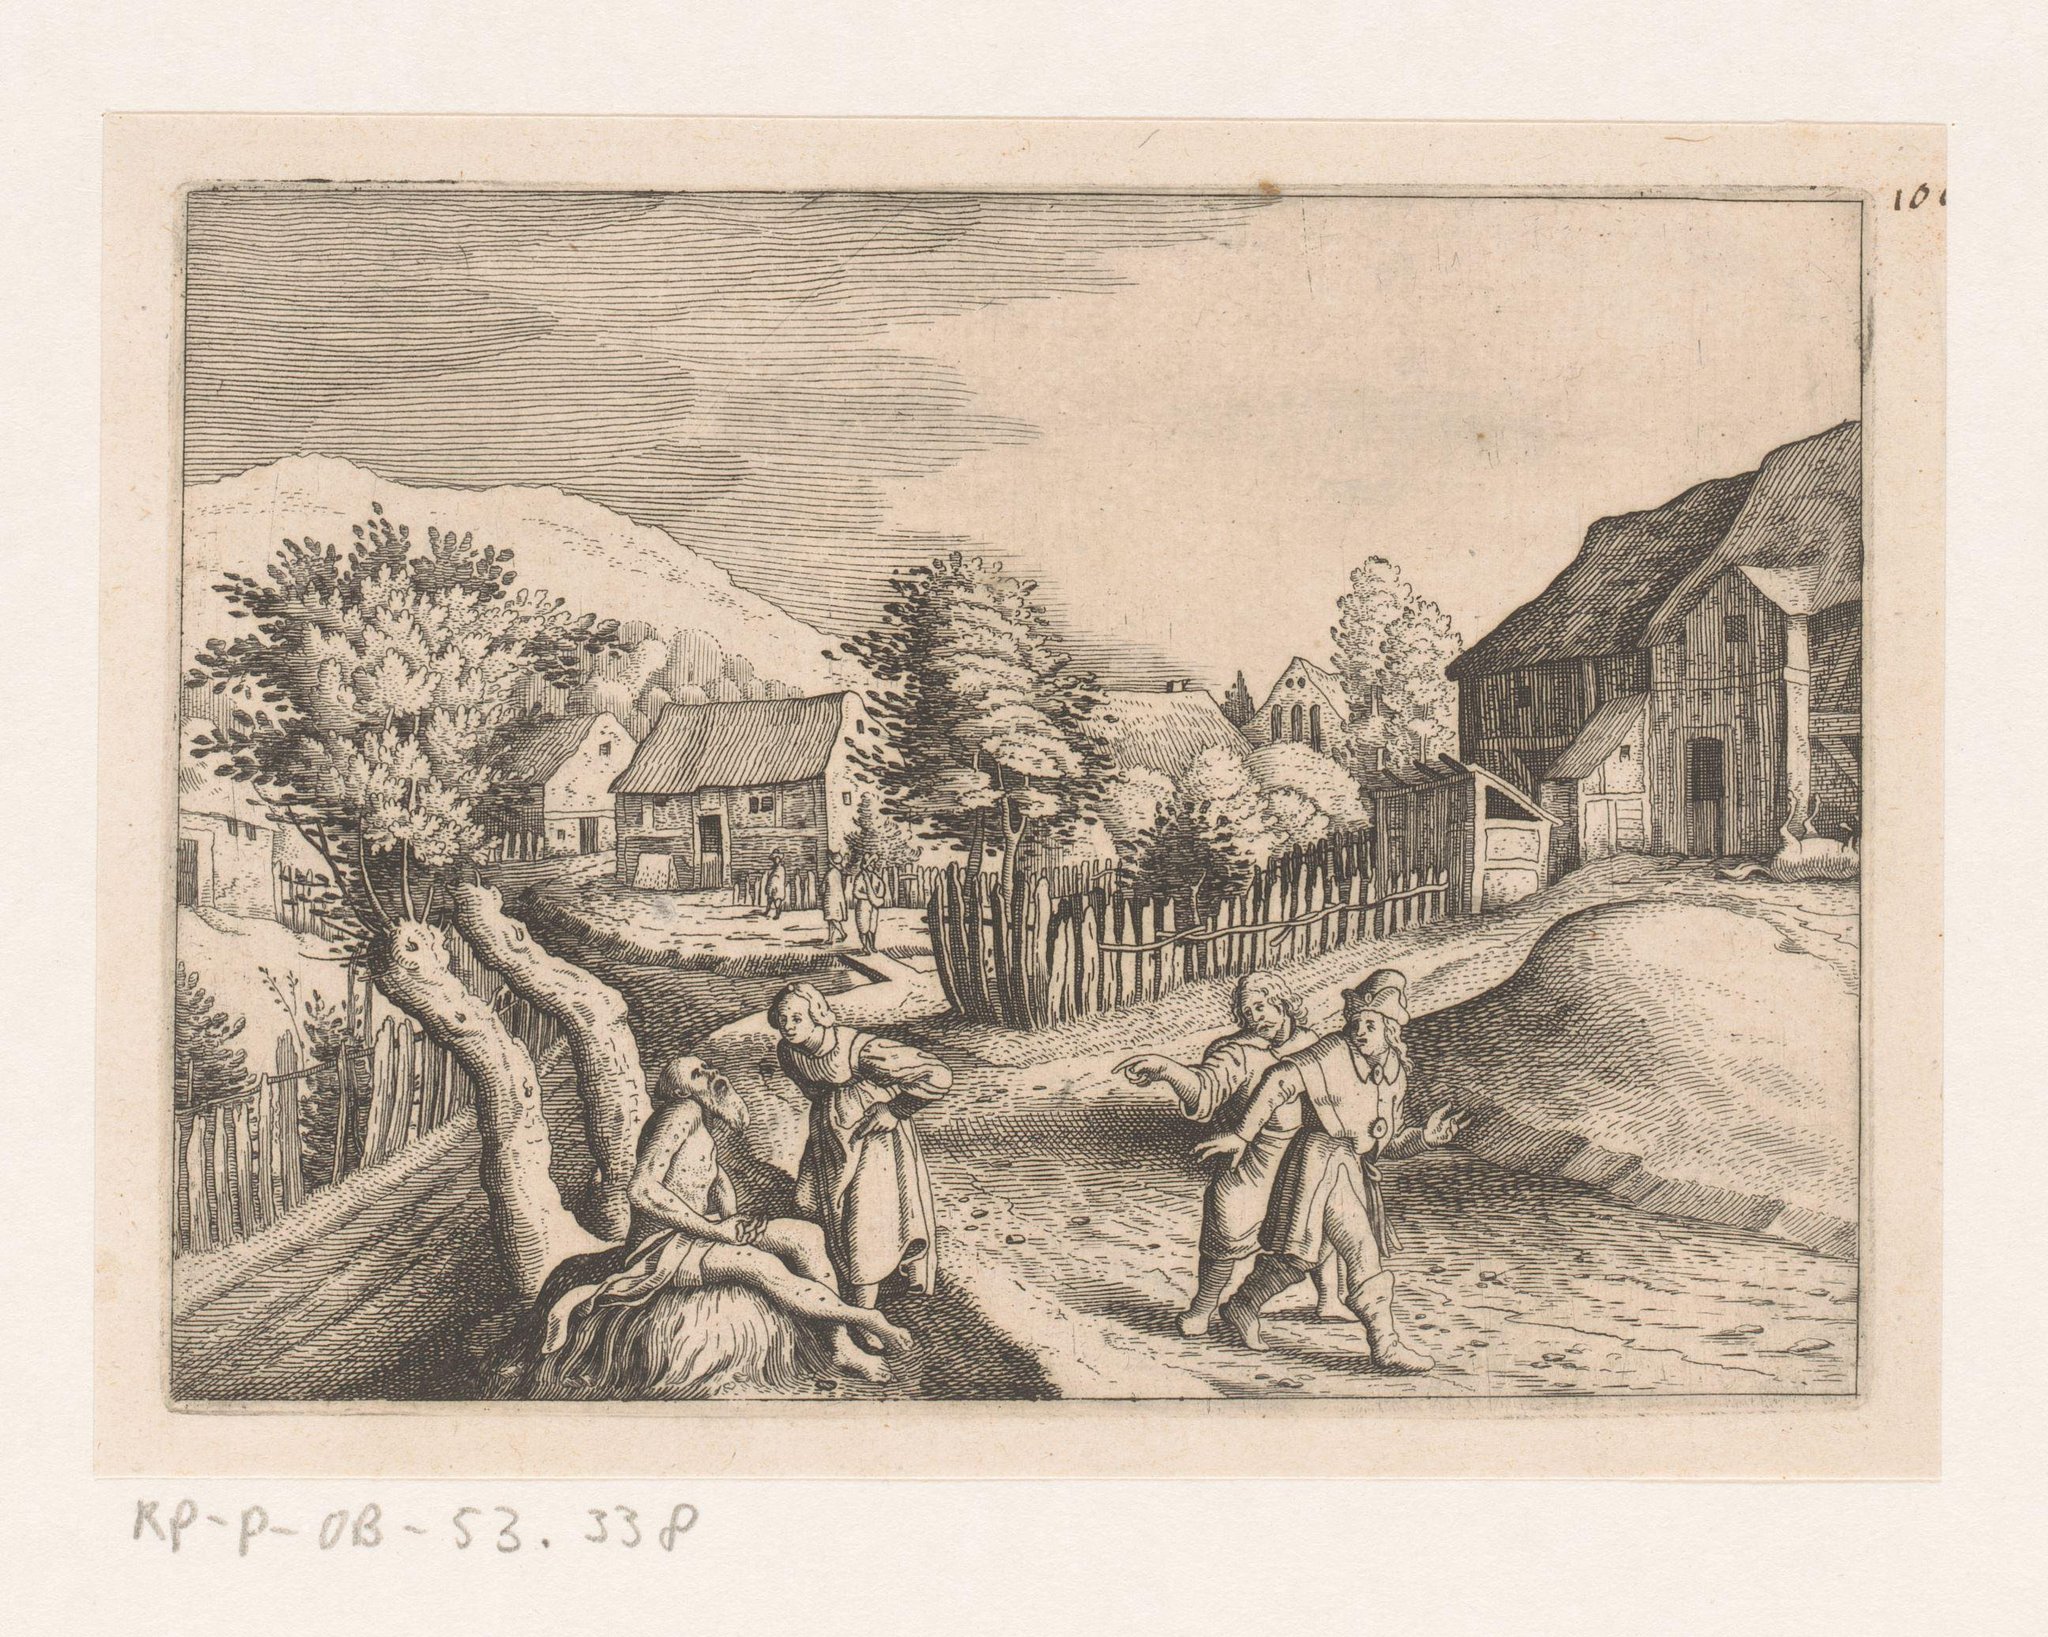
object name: print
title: Kopiëen naar de Schwalbacher Reise-serie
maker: Anonymous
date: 1620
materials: paper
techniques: etching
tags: trees, village street, road, path, job on the dunghill visited by his wife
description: Kopie in spiegelbeeld naar de prent van Matthäus Merian I (Hollstein German XXV 264).